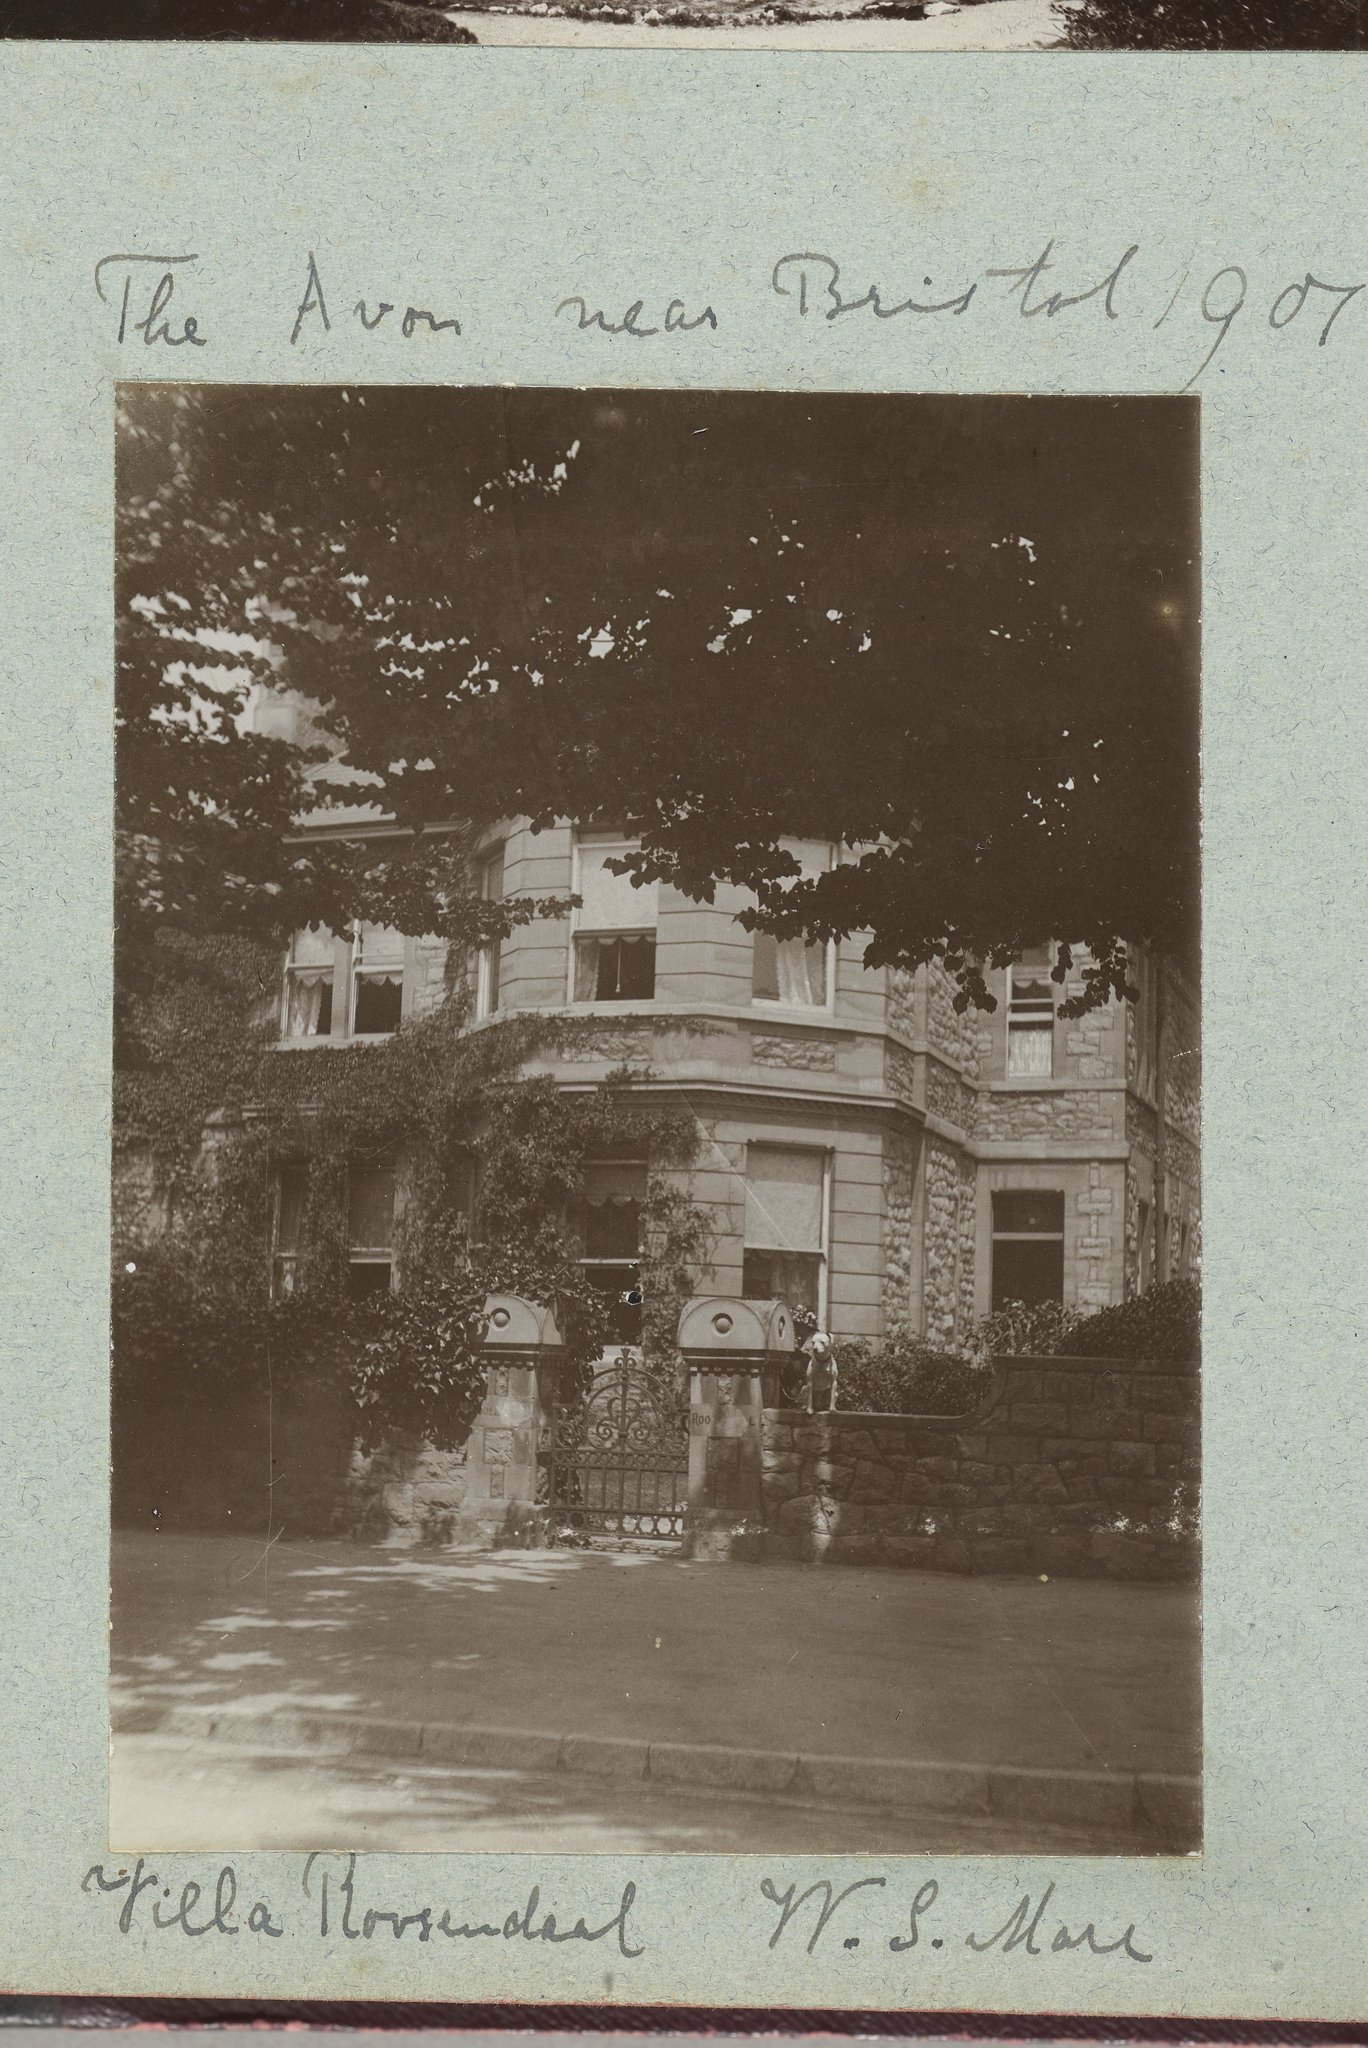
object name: photograph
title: Villa Roosendaal W.S.Mare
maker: frits freerks fontein fz.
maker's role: fotograaf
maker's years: 1882-1928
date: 1901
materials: cardboard, paper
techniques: gelatin silver print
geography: england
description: Weston-Super-Mare is een badplaats in Groot-Brittannië. Foto uit album 'Photographieën".